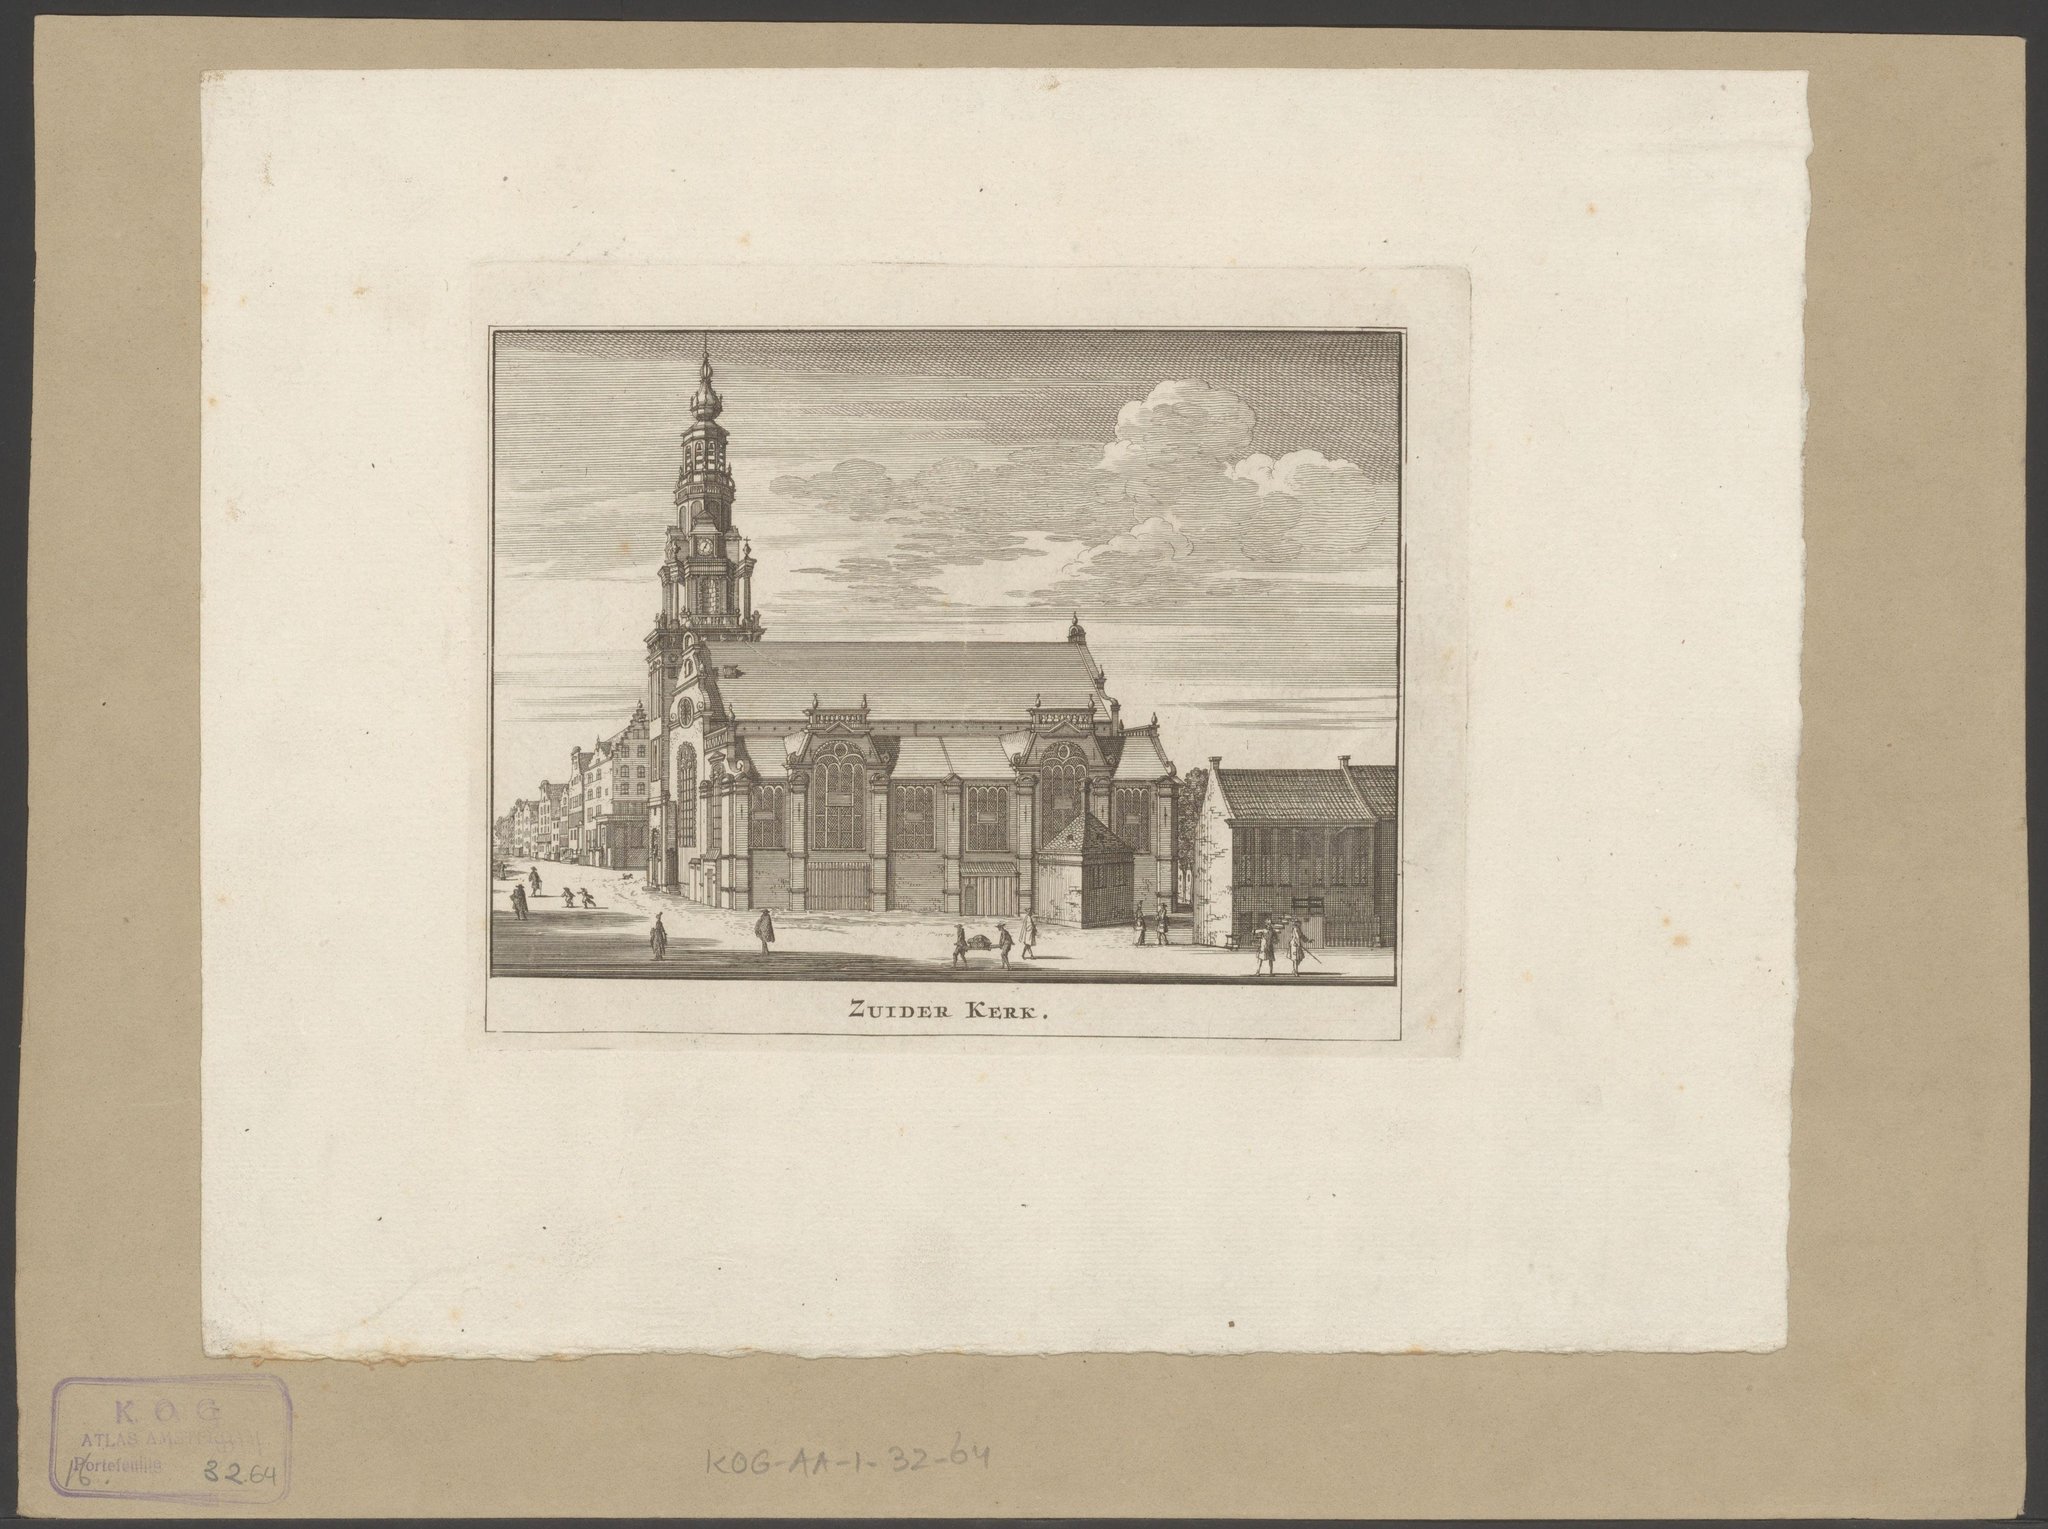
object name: print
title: Gezicht op de Zuiderkerk te Amsterdam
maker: Anonymous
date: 1751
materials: paper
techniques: engraving, etching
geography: northern netherlands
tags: church (exterior), street (+ city(-scape) with figures, staffage)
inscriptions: collector's mark: Lugt 1641b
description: Eerste staat van prent, genummerd 182, gebruikt in: Hoorn, Nicolaas ten. Wegwyzer door Amsterdam zynde eene beknopte verhandeling van desselfs eerste opkomst, vergrootingen, en teegenwoordigen staat (...). Amsterdam: Nicolaas ten Hoorn, 1713. En in: Hoorn, Nicolaas ten. Wegwyzer door Amsterdam zynde eene beknopte verhandeling van desselfs eerste opkomst, vergrootingen, en teegenwoordigen staat (...). Amsterdam: Nicolaas ten Hoorn, 1726. Tweede staat van prent, genummerd 193, gebruikt in: Hoorn, Nicolaas ten. Wegwyzer door Amsterdam zynde eene beknopte verhandeling van desselfs eerste opkomst, vergrootingen, en teegenwoordigen staat (...). Amsterdam: Nicolaas ten Hoorn, 1726. En in: Hoorn, Nicolaas ten. Wegwyzer, of korte beschryvinge van de stadt Amsterdam, zynde eene beknopte verhandeling van desselfs eerste opkomst, vergrootingen, en teegenwoordigen staat (...). Amsterdam: erven J. Ratelband & Co, 1737. En in: Hoorn, Nicolaas ten. Wegwyzer of korte beschryvinge der stad Amsterdam, zynde eene beknopte verhandeling van derzelver eerste opkomst, vergrootingen, en tegenwoordigen staat (...). Amsterdam: Pieter Meyer, 1751.